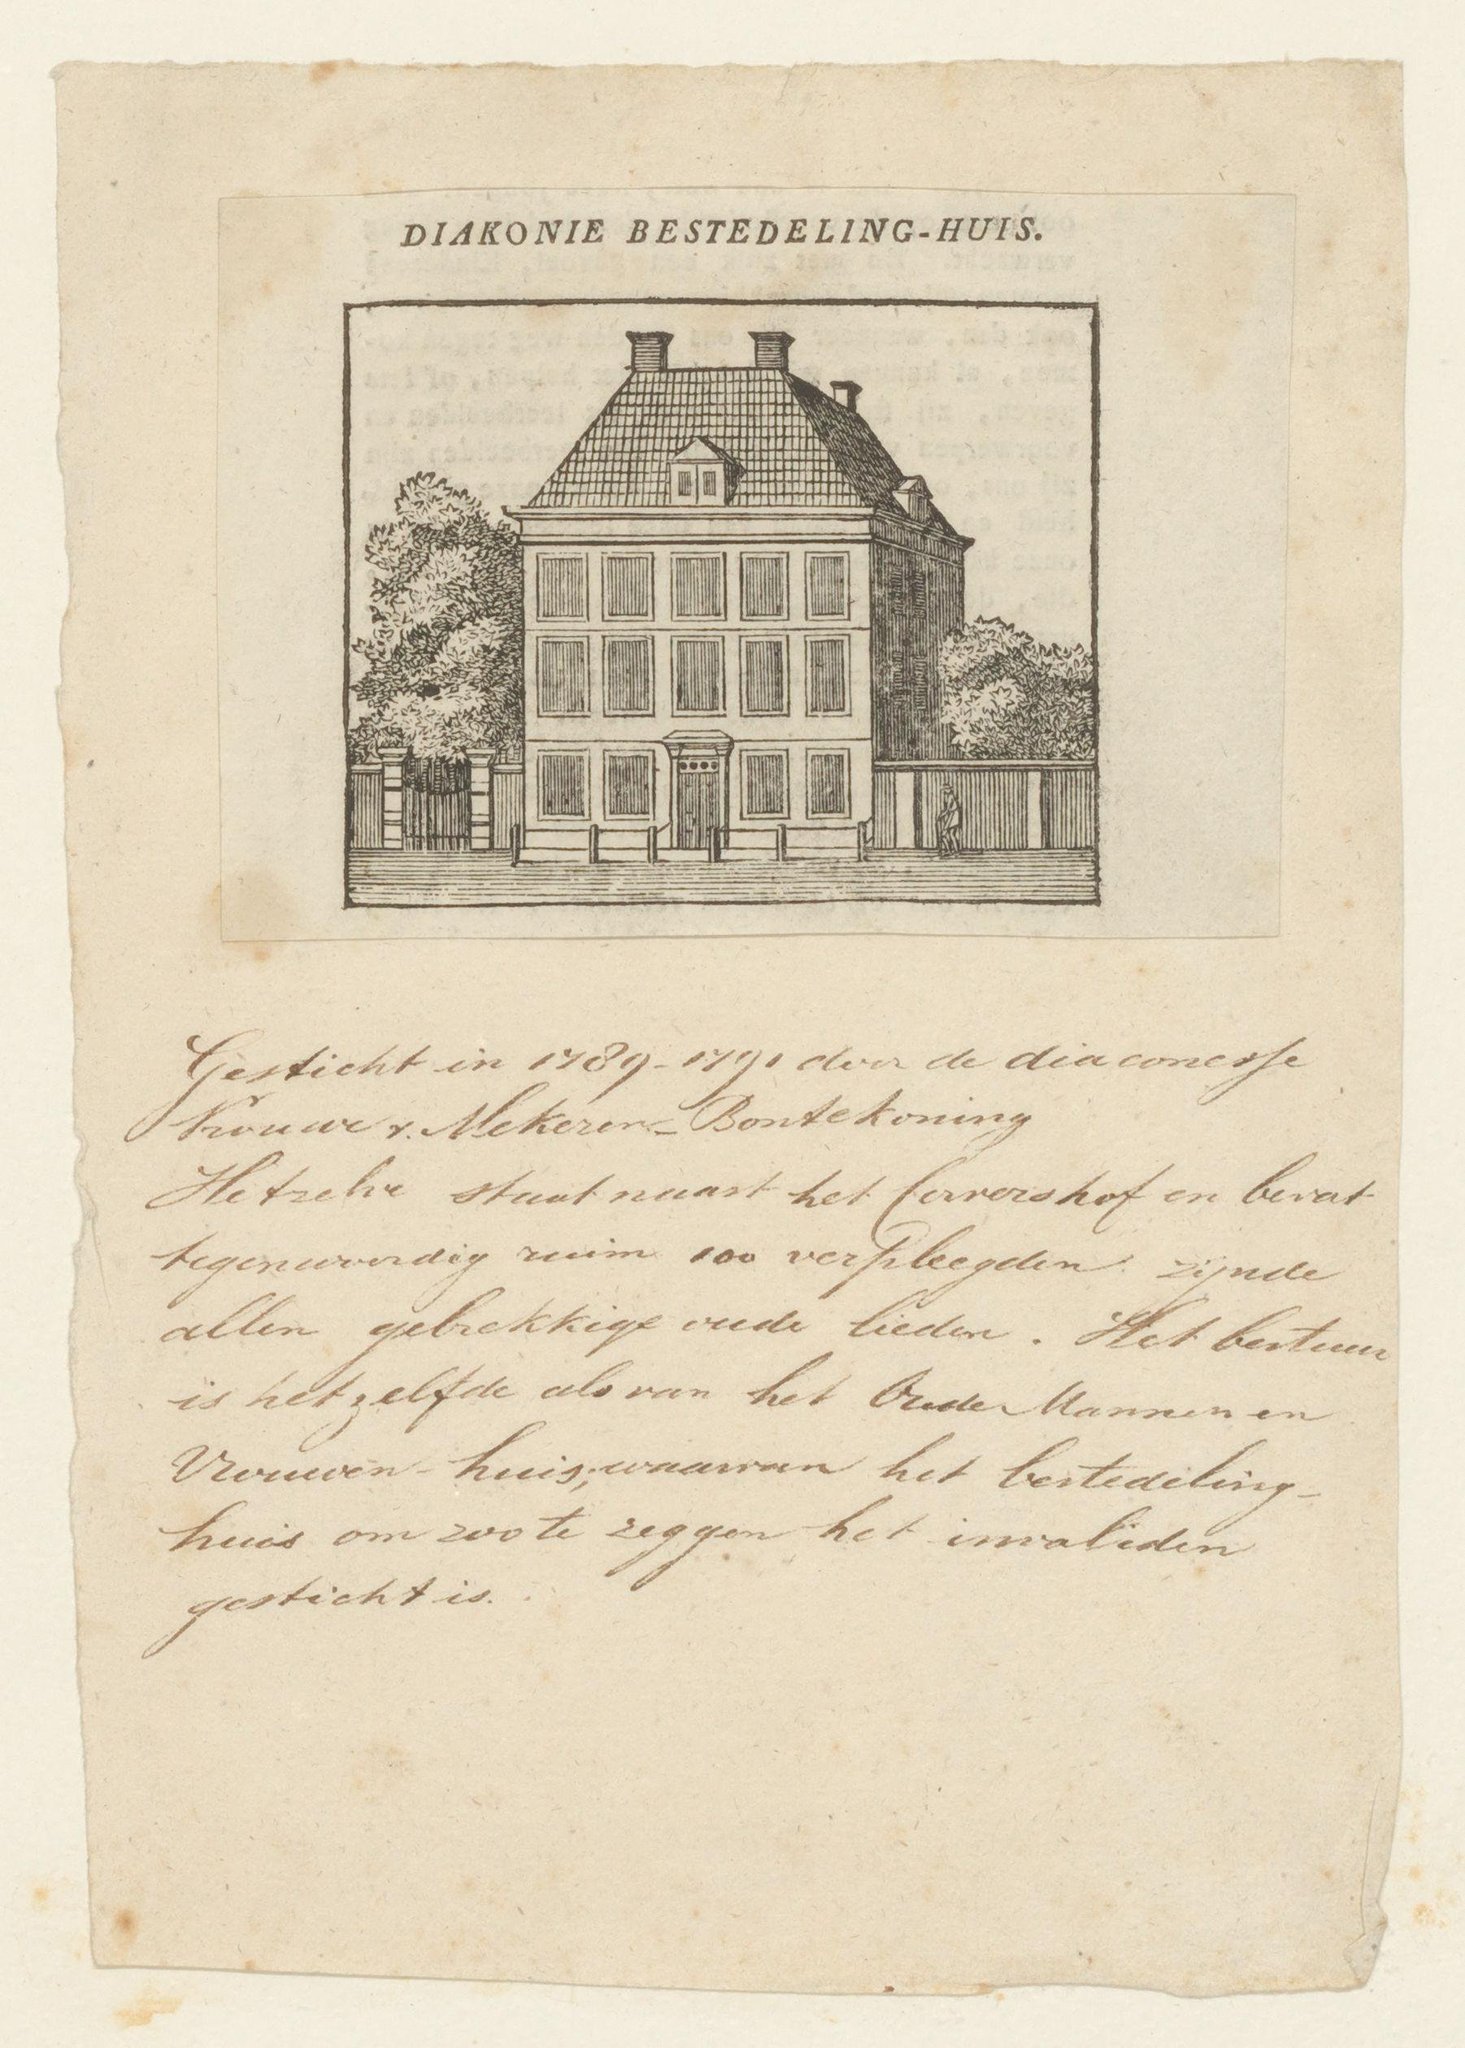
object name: print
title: Diakonie Bestedeling-Huis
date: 1817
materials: paper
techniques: letterpress printing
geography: netherlands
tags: poorhouse, orphanage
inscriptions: collector's mark: Lugt 1641b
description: Onderwerpsrubriek binnen de Atlas Amsterdam: Armwezen en liefdadige instellingen: II. Kerkelijke inrichtingen: Bestedingshuis der Ned. Herv. Gemeente.